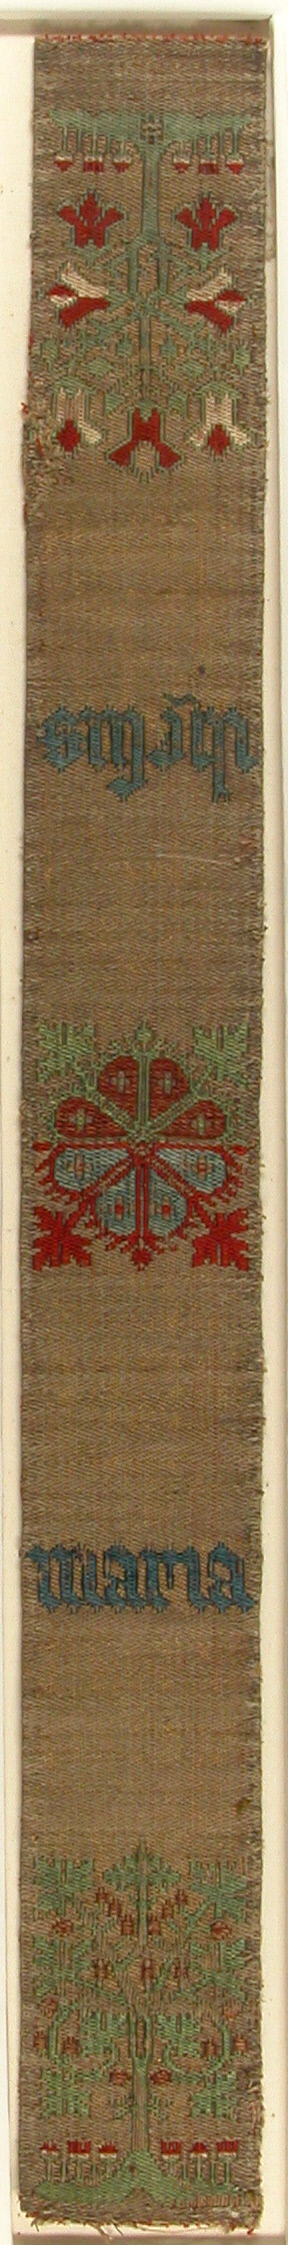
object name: band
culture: german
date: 1401-1500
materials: metal thread, silk